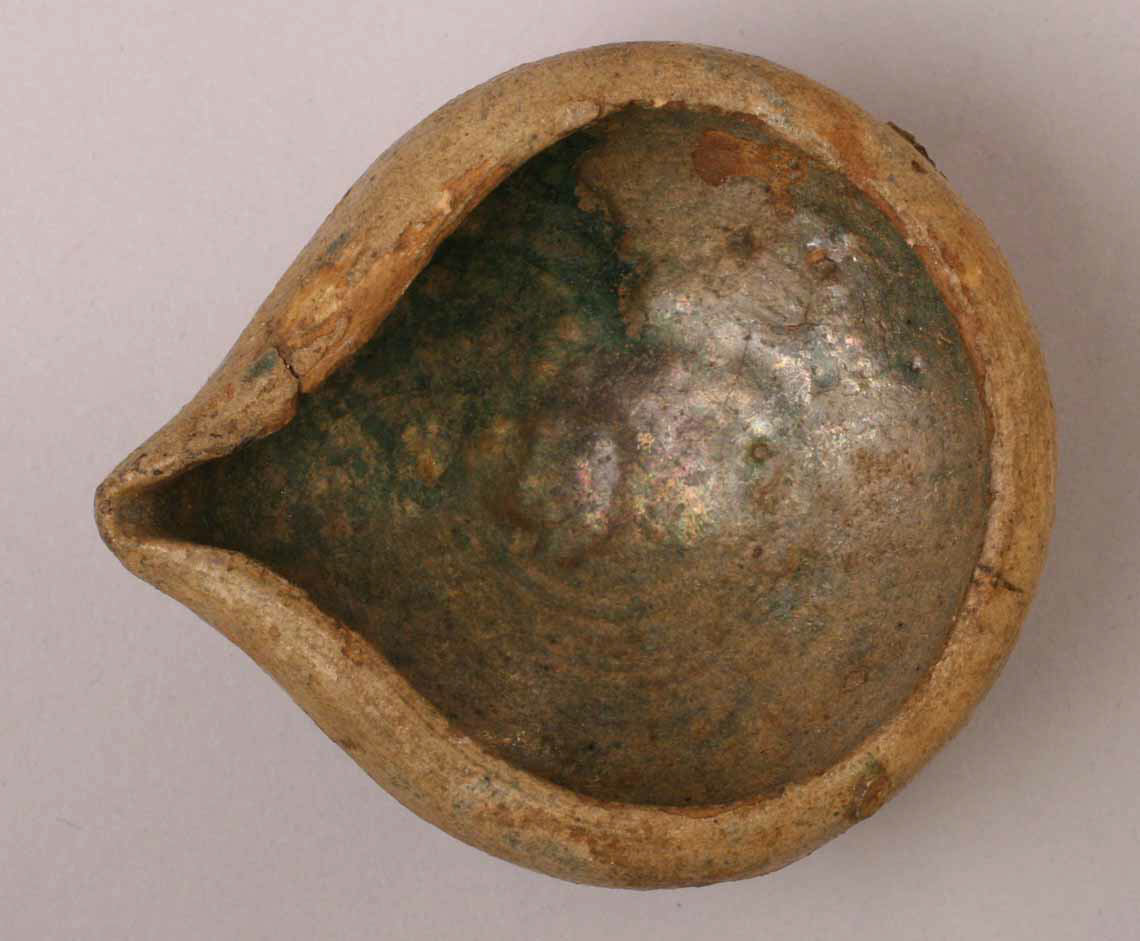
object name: lamp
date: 701-900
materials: earthenware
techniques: glazing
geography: iran